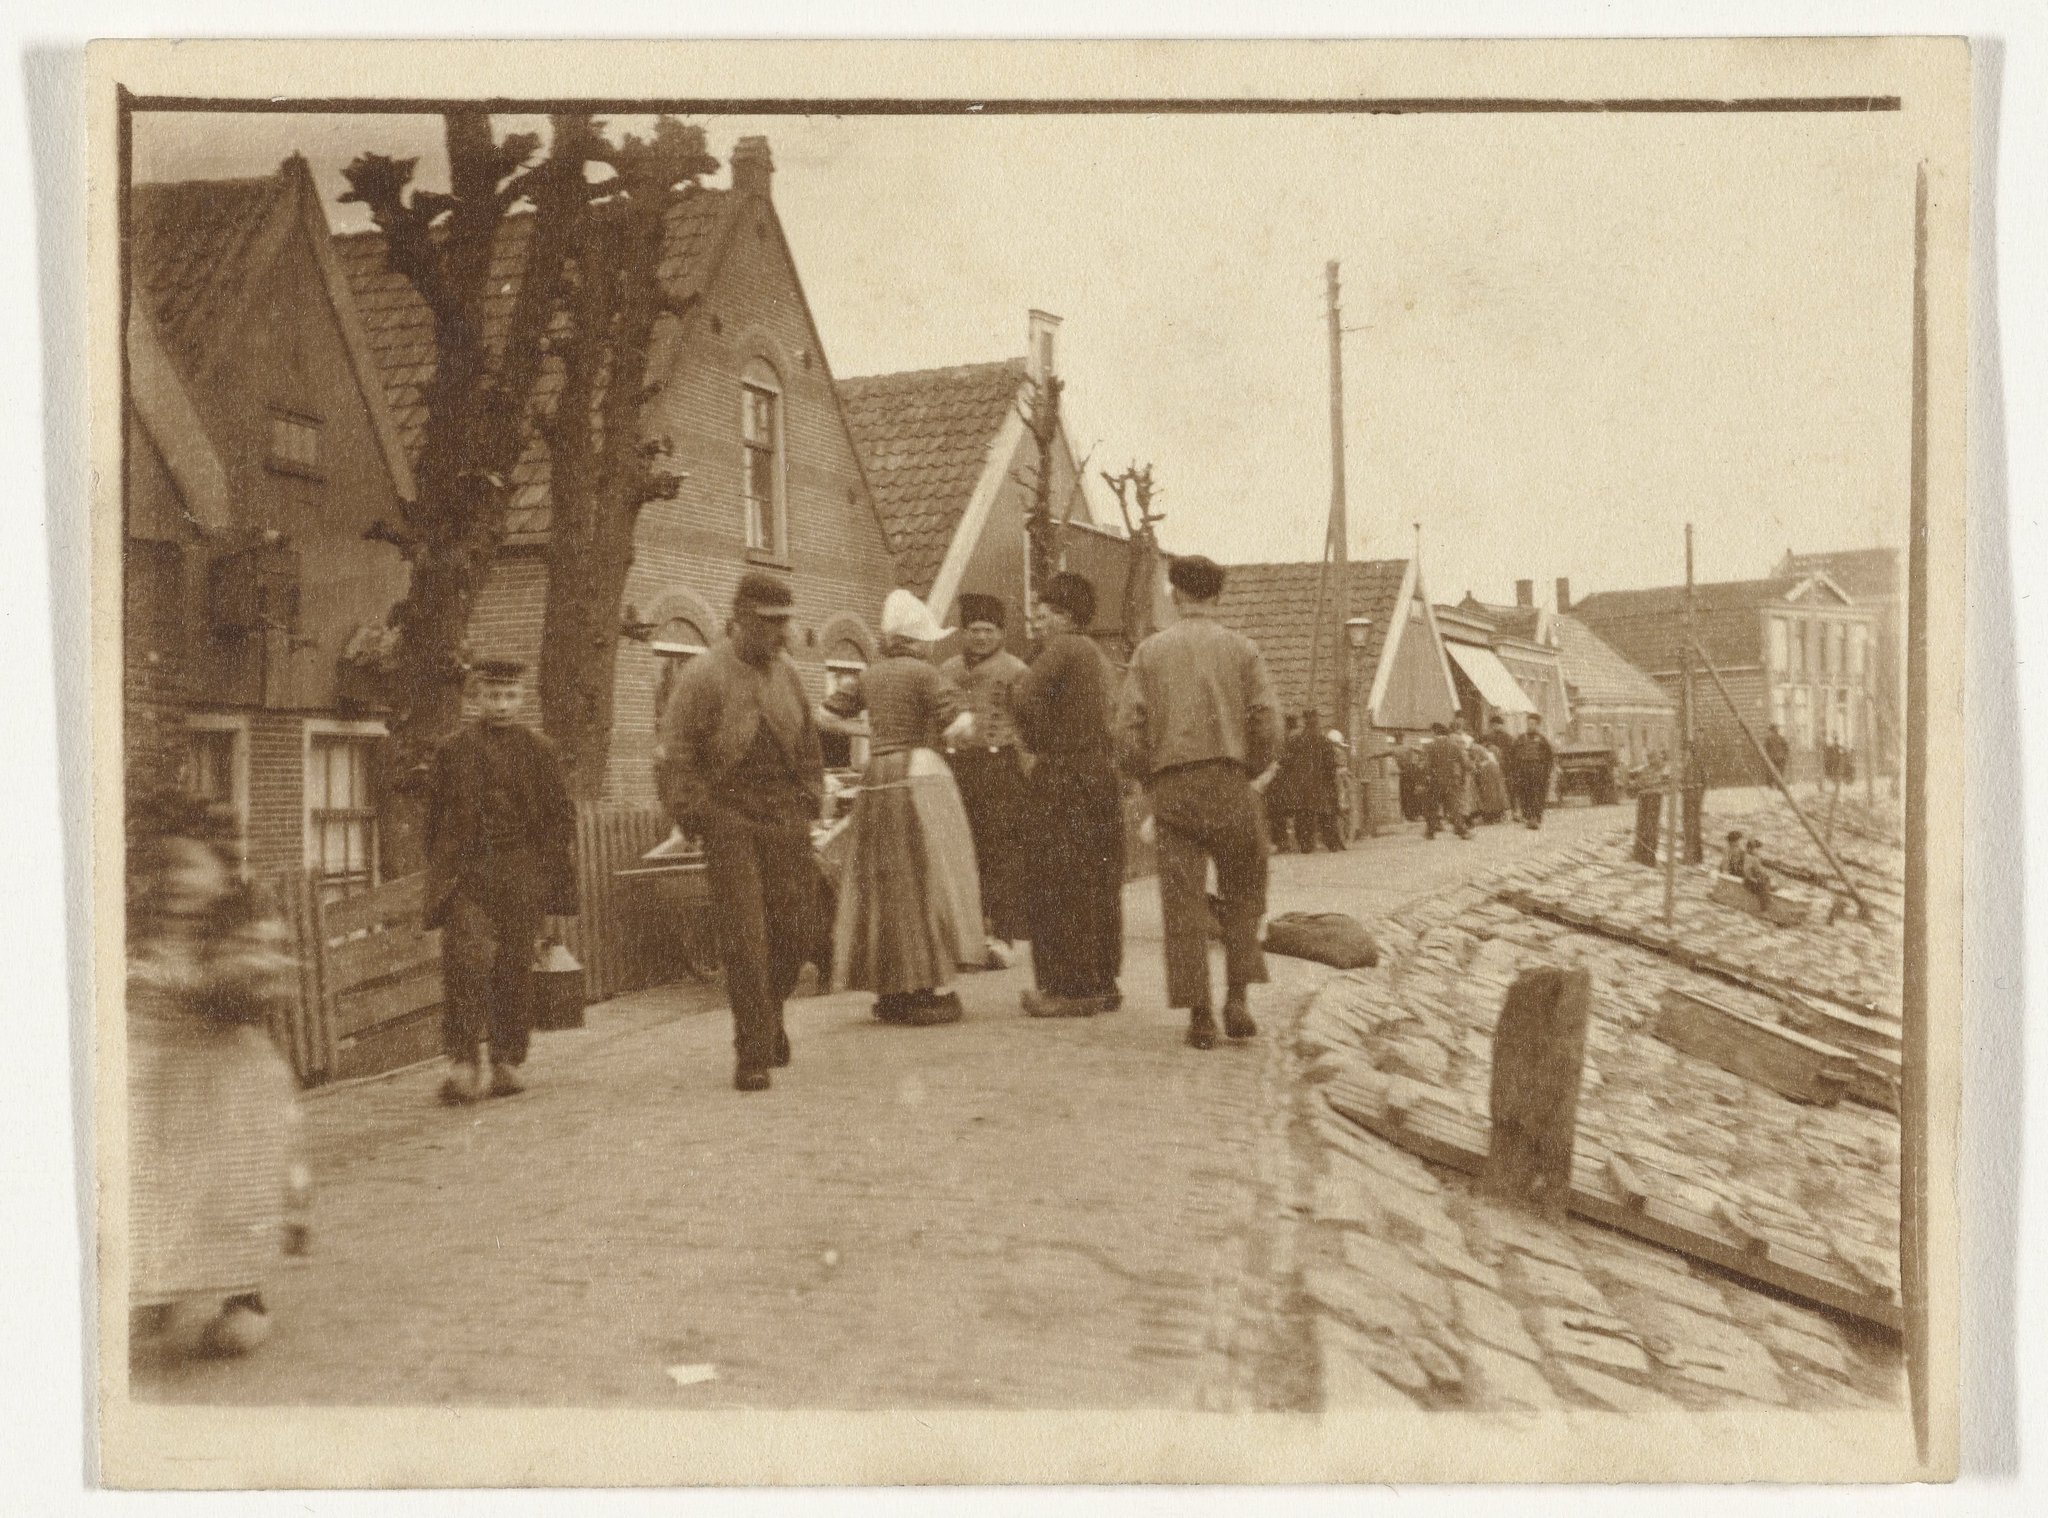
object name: photograph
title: Gezicht op een dijk in Volendam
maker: george hidderley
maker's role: fotograaf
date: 1900-1910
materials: photographic support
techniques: salted paper print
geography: volendam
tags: folk costume, regional costume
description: Was oorspronkelijk los ingevoegd in album RP-F-2002-105